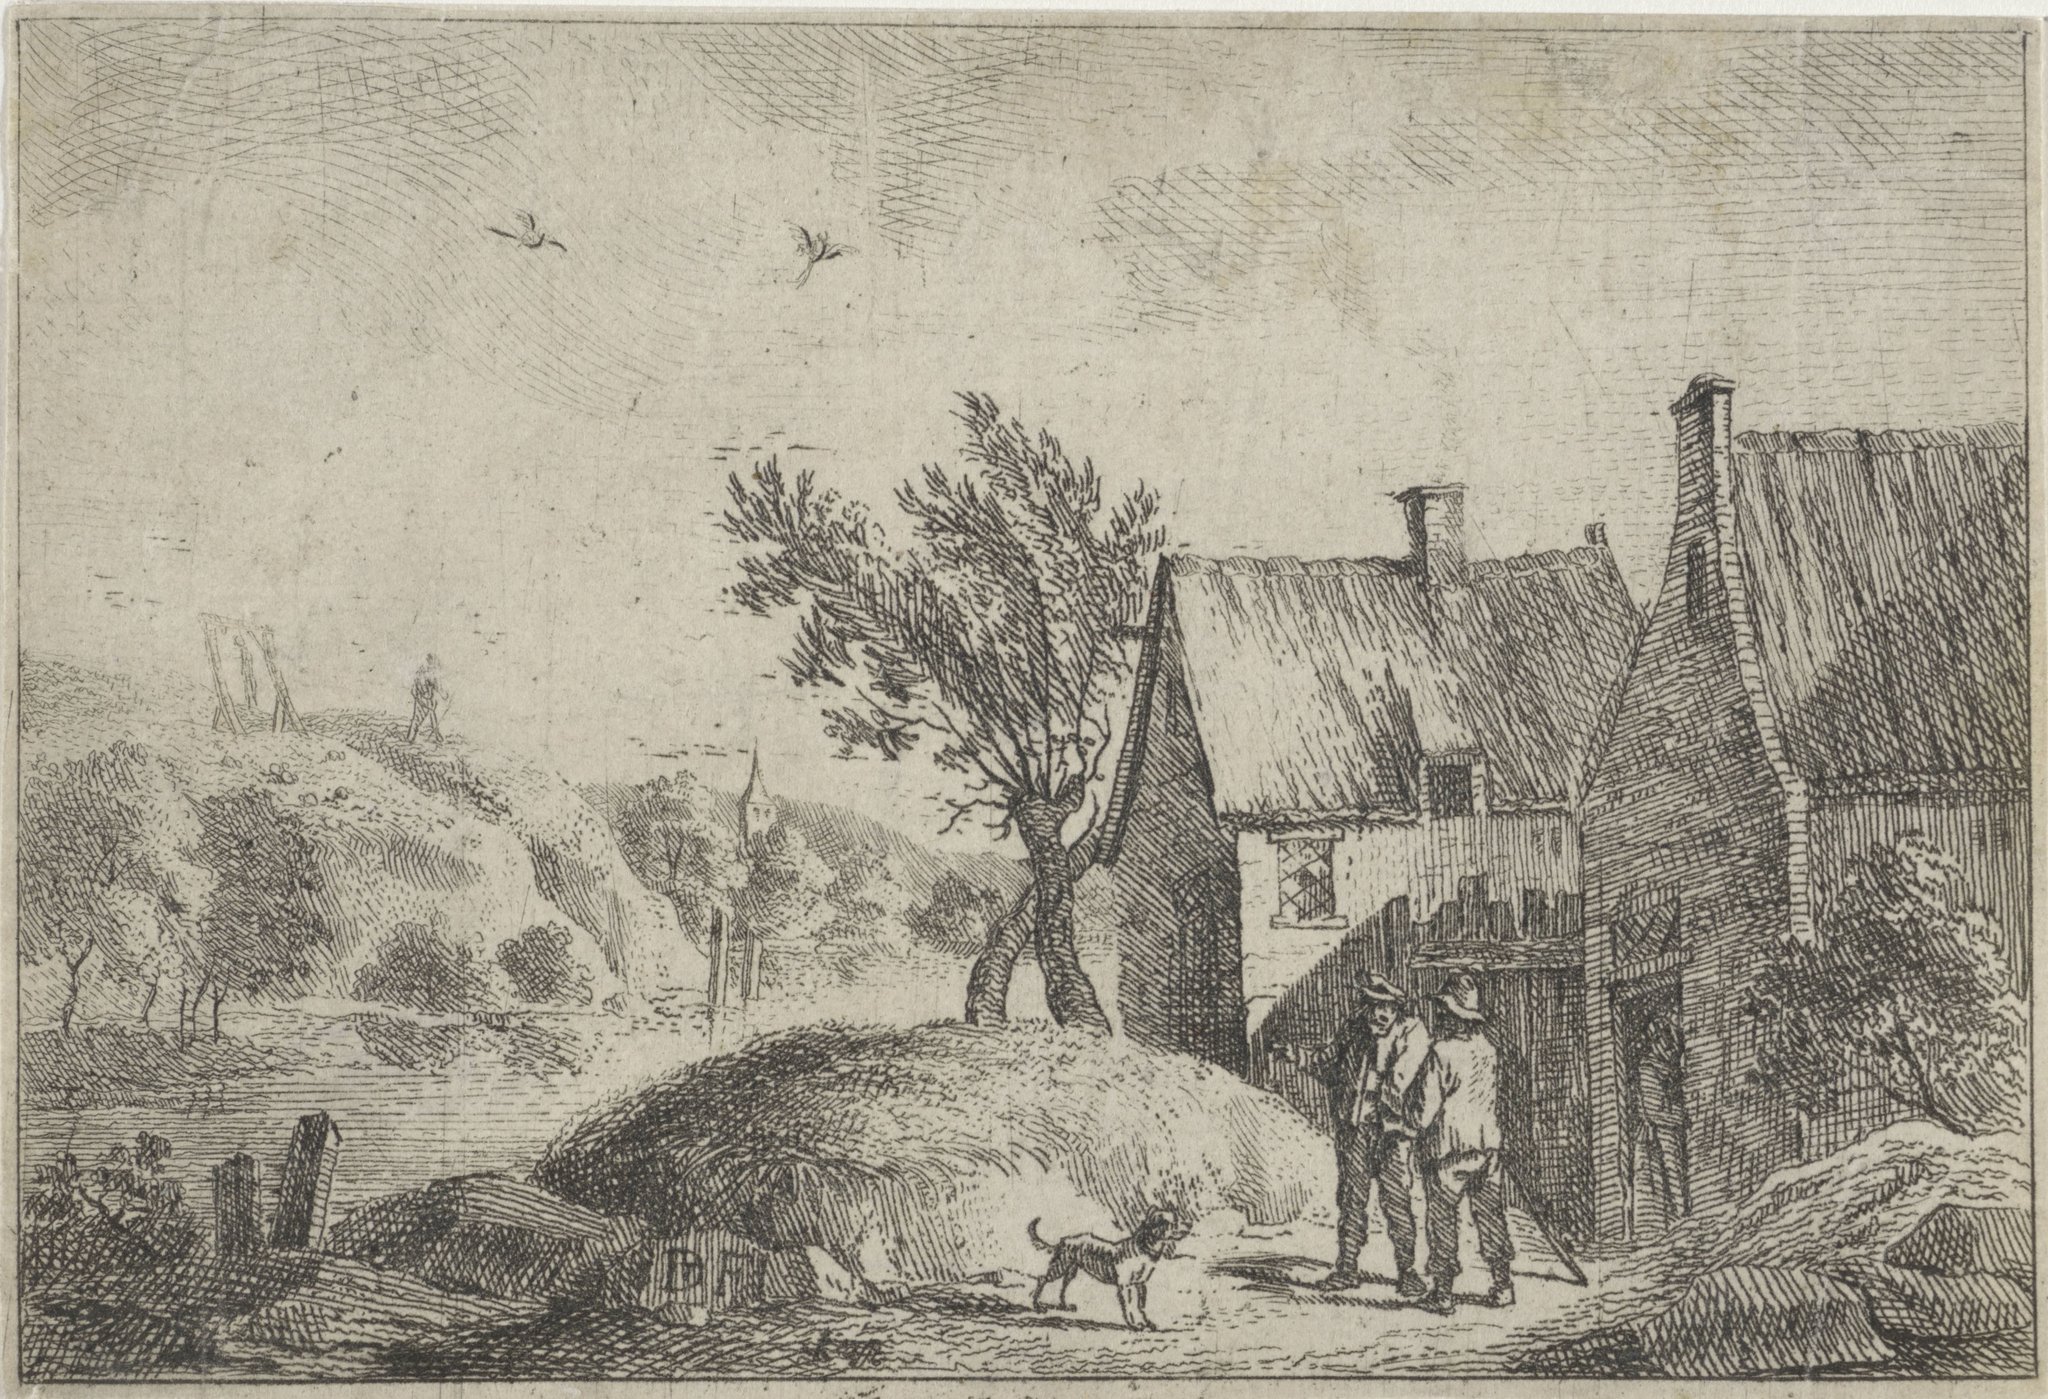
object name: print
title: Twee mannen met een hond in een landschap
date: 1704-1765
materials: paper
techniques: etching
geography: southern netherlands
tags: farm or solitary house in landscape, dog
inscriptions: collector's mark: Lugt 2228, collector's mark: Lugt 899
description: Rechts twee huizen in een landschap. Daarbij staan twee mannen en een hond. Links op de heuvel een galg met een gehangene.